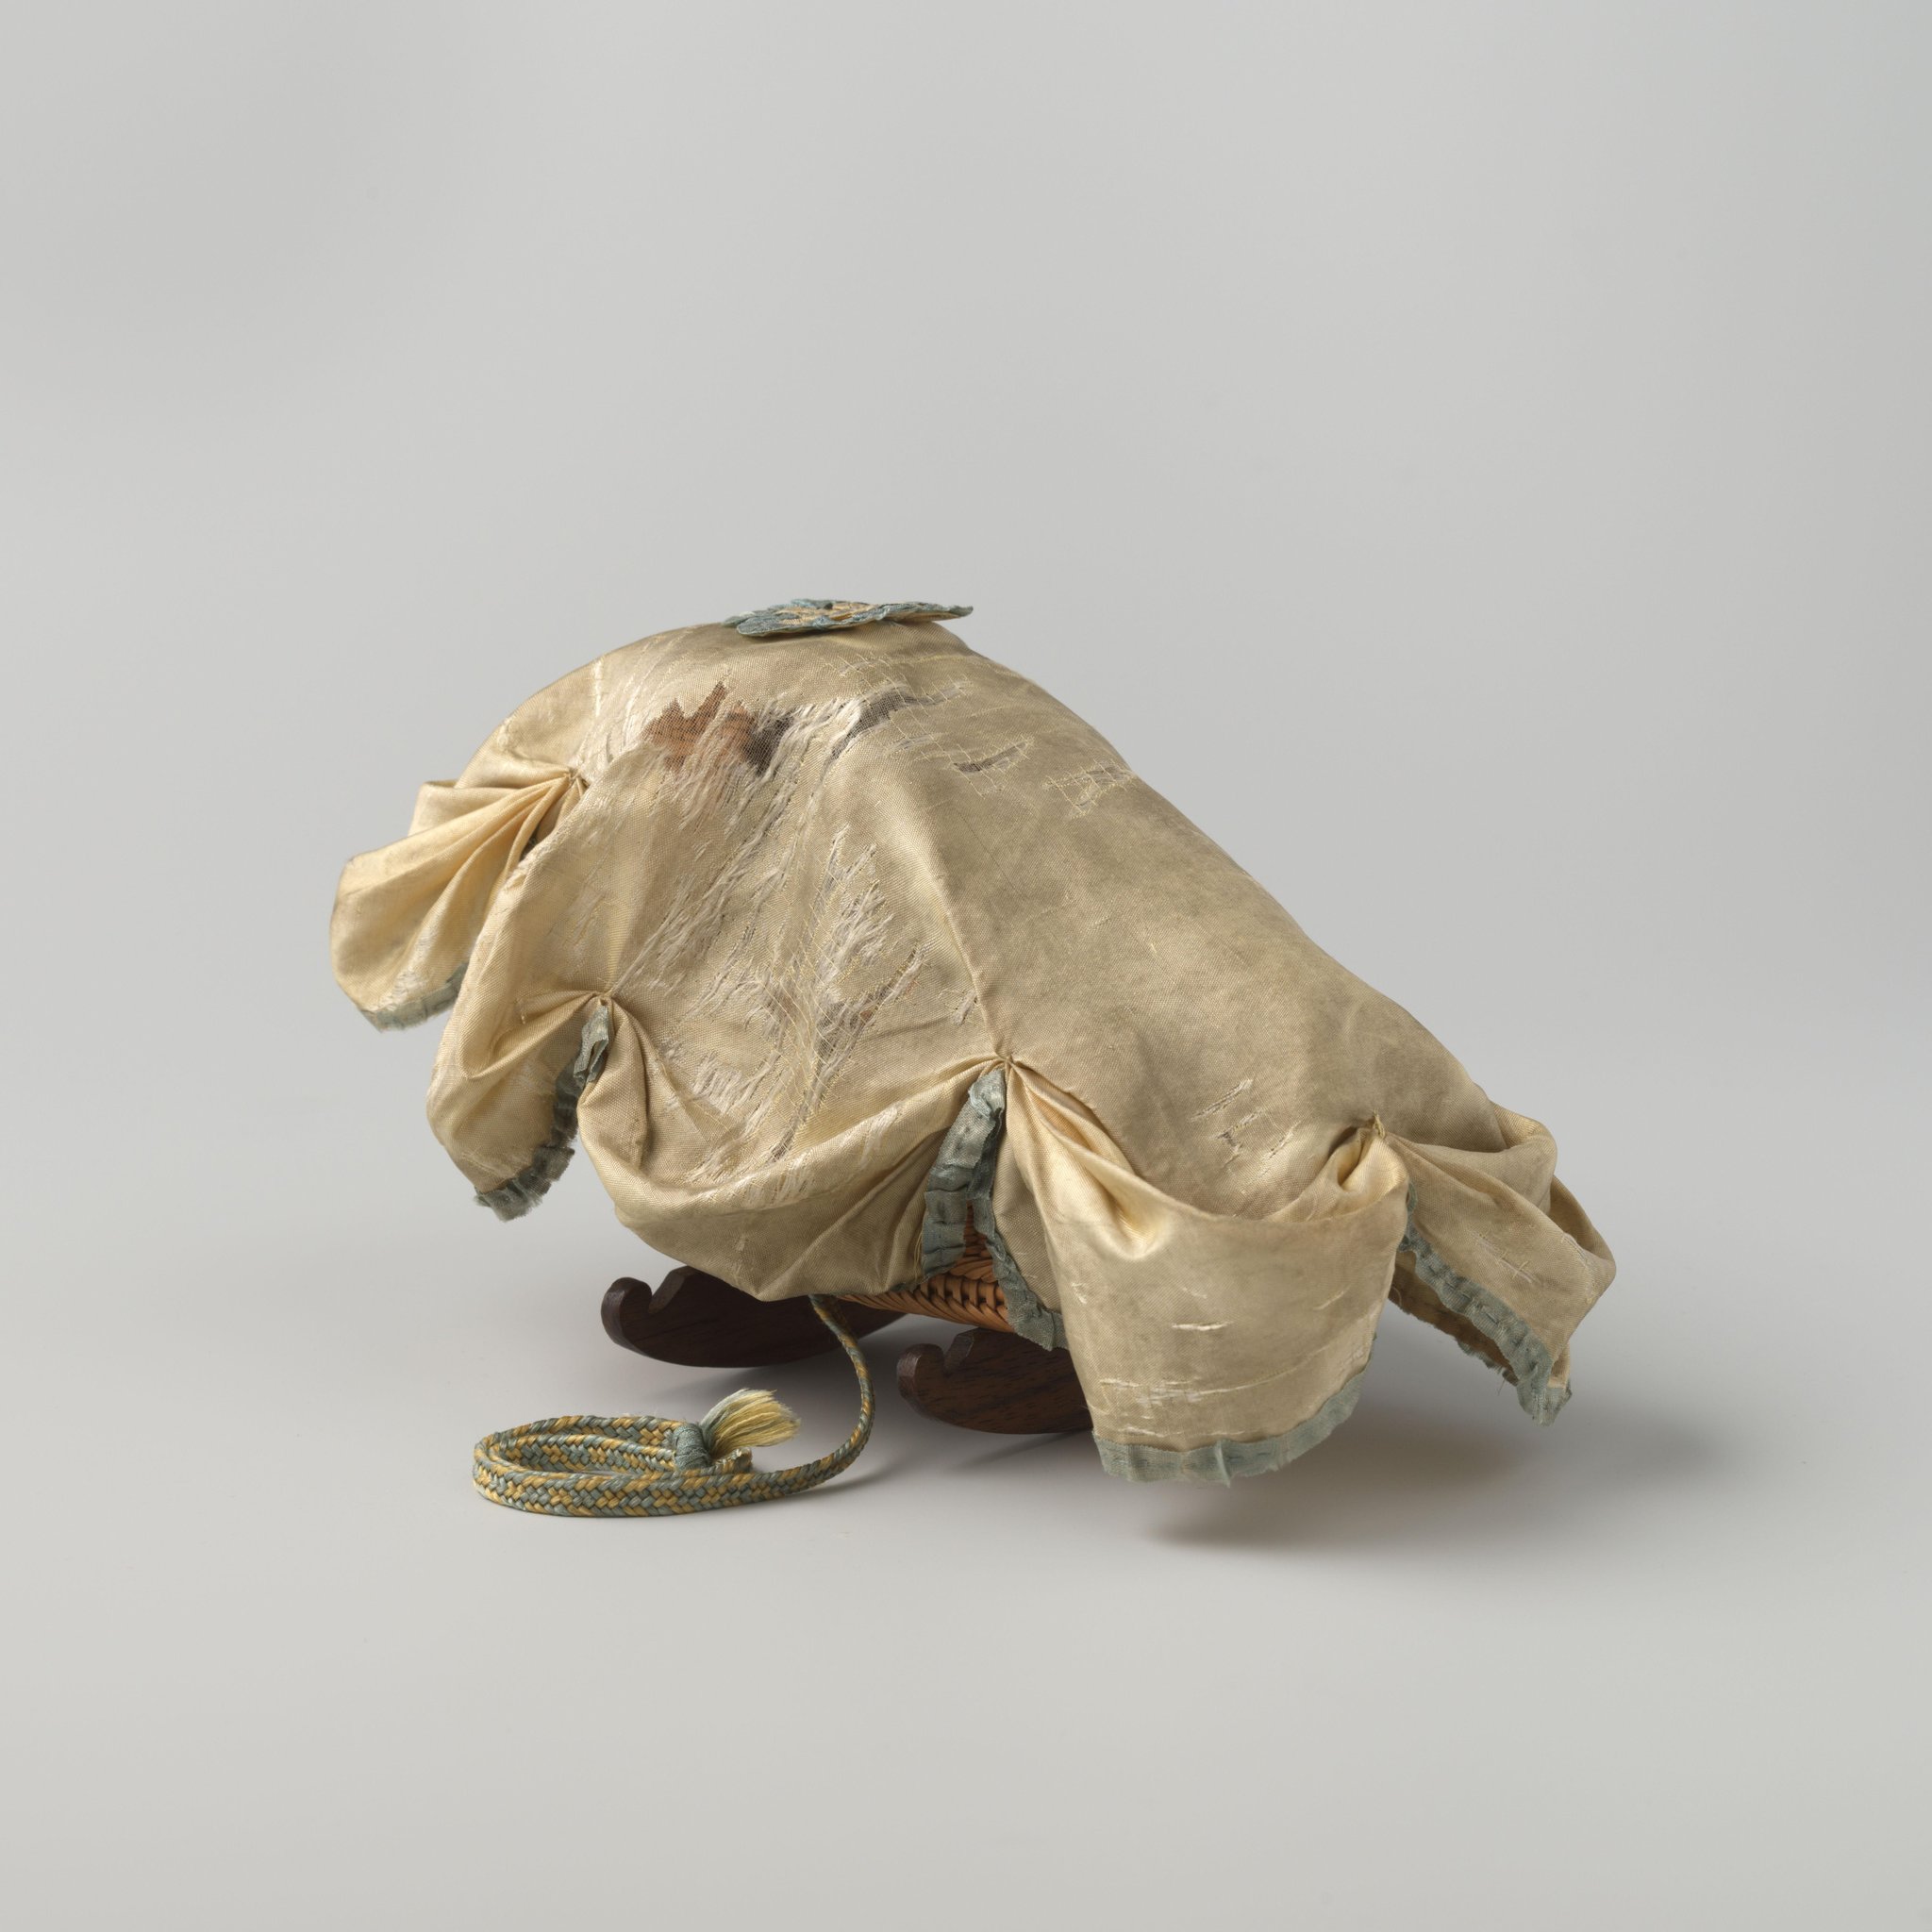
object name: wieg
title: Wieg van gespleten wilgenteen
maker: Anonymous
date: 1690-1710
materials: plant material, wood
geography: amsterdam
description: Wieg van gespleten wilgenteen, fijnscheenwerk, rustend op twee schenkels met verbindingslat van notenhout, aan de wieg verbonden met vier schroeven en ringen ('revetjes') van binnen uit. Ovale wieg met vaste kap, scheenwerk versierd met ribbels; vier handvatten, aan één is een schommelkoord geknoopt van gevlochten gele en blauwe zijde, eindigend in een geel en blauw zijden kwast.